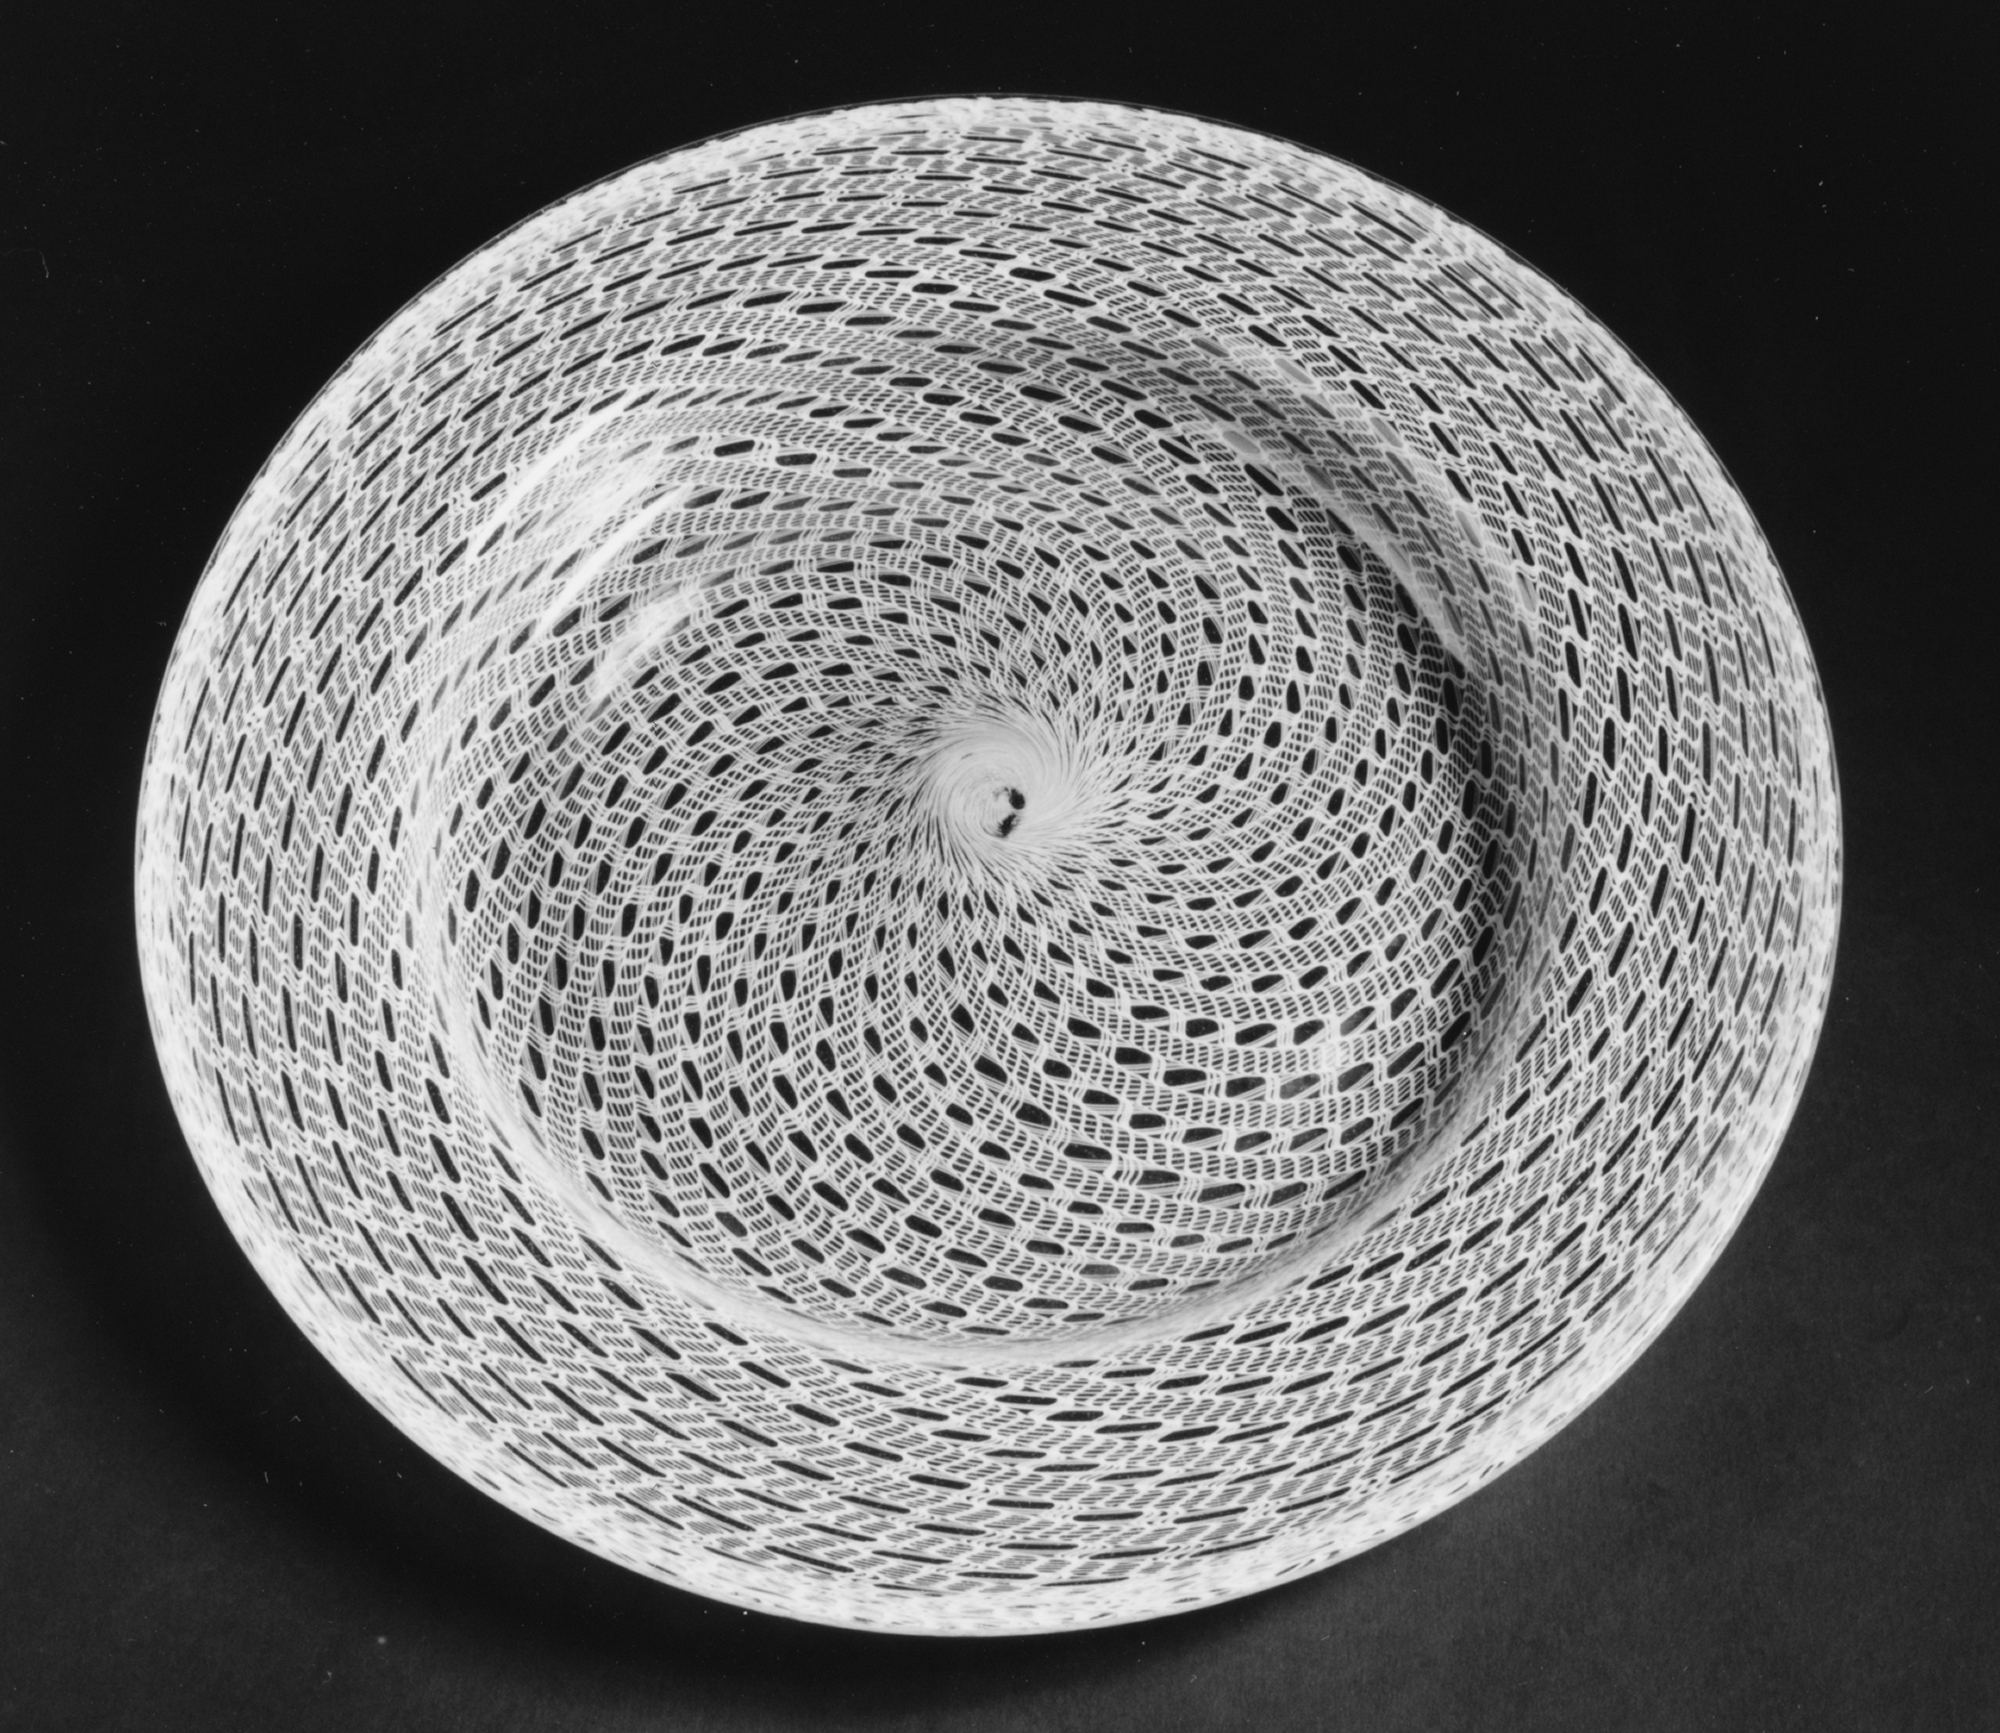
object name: plate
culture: italian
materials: glass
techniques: glassblowing